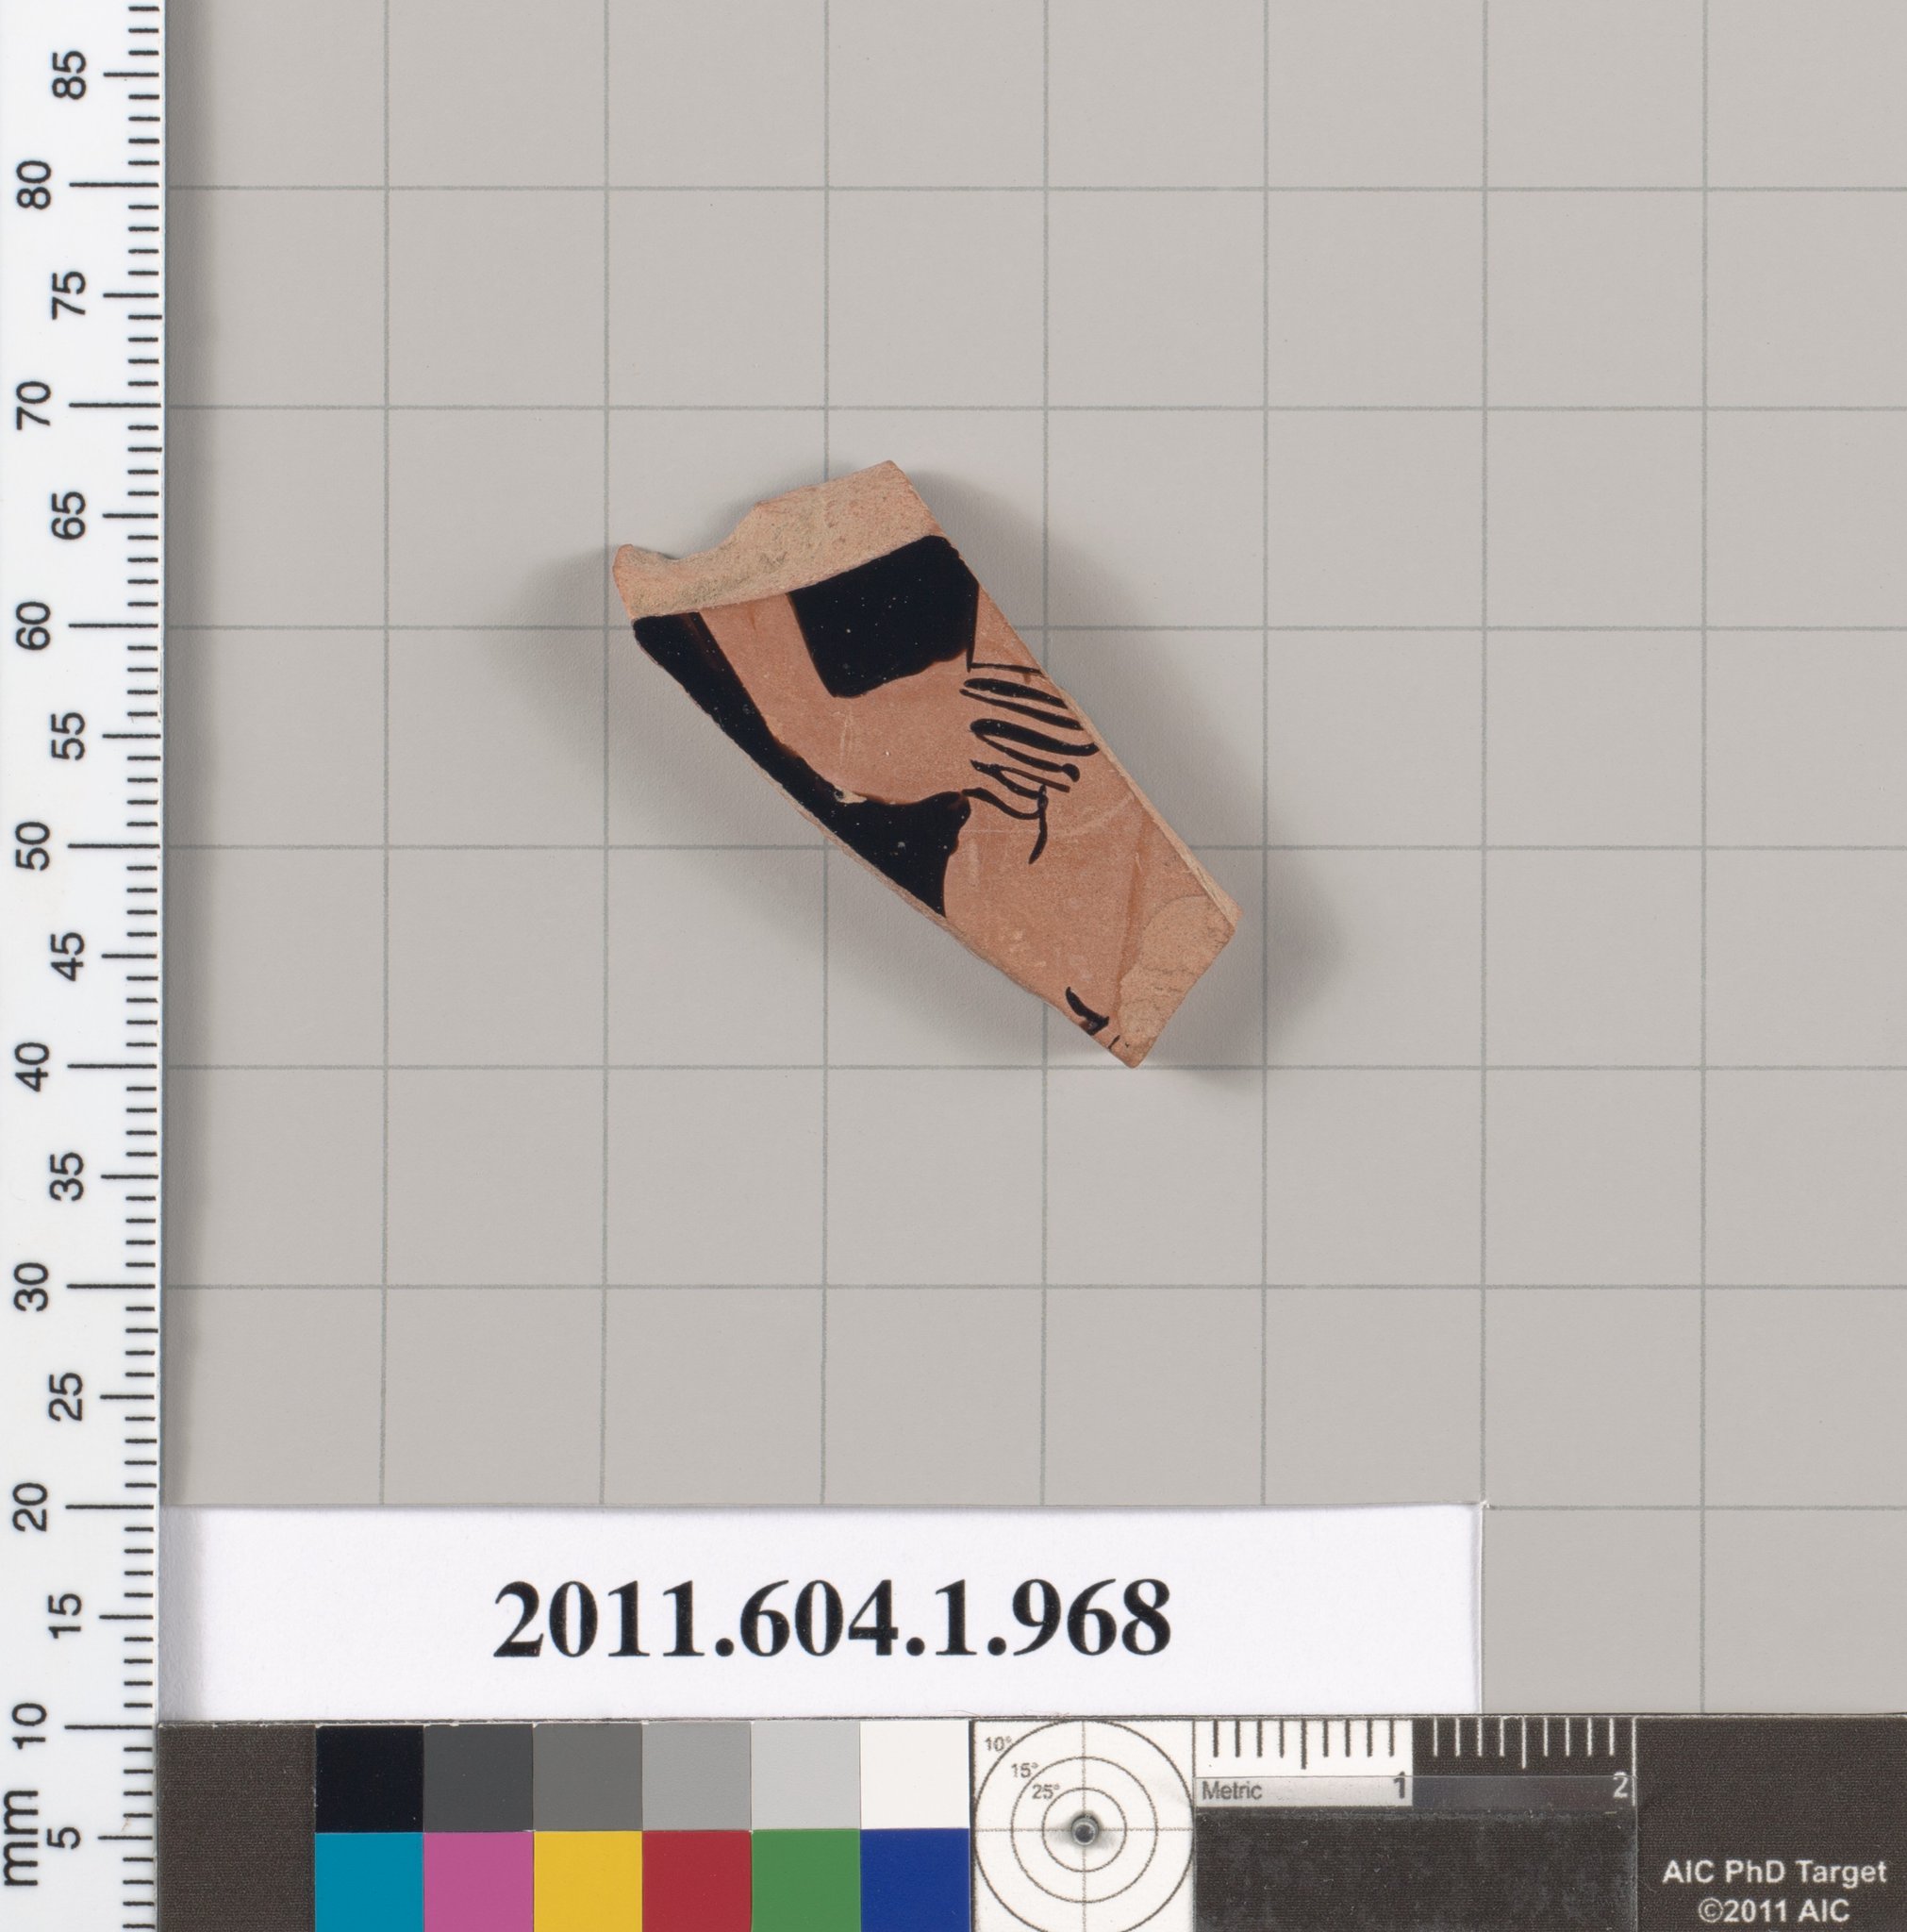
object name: kylix fragment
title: Terracotta fragment of a kylix (drinking cup)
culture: greek, attic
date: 490-480 BCE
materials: terracotta